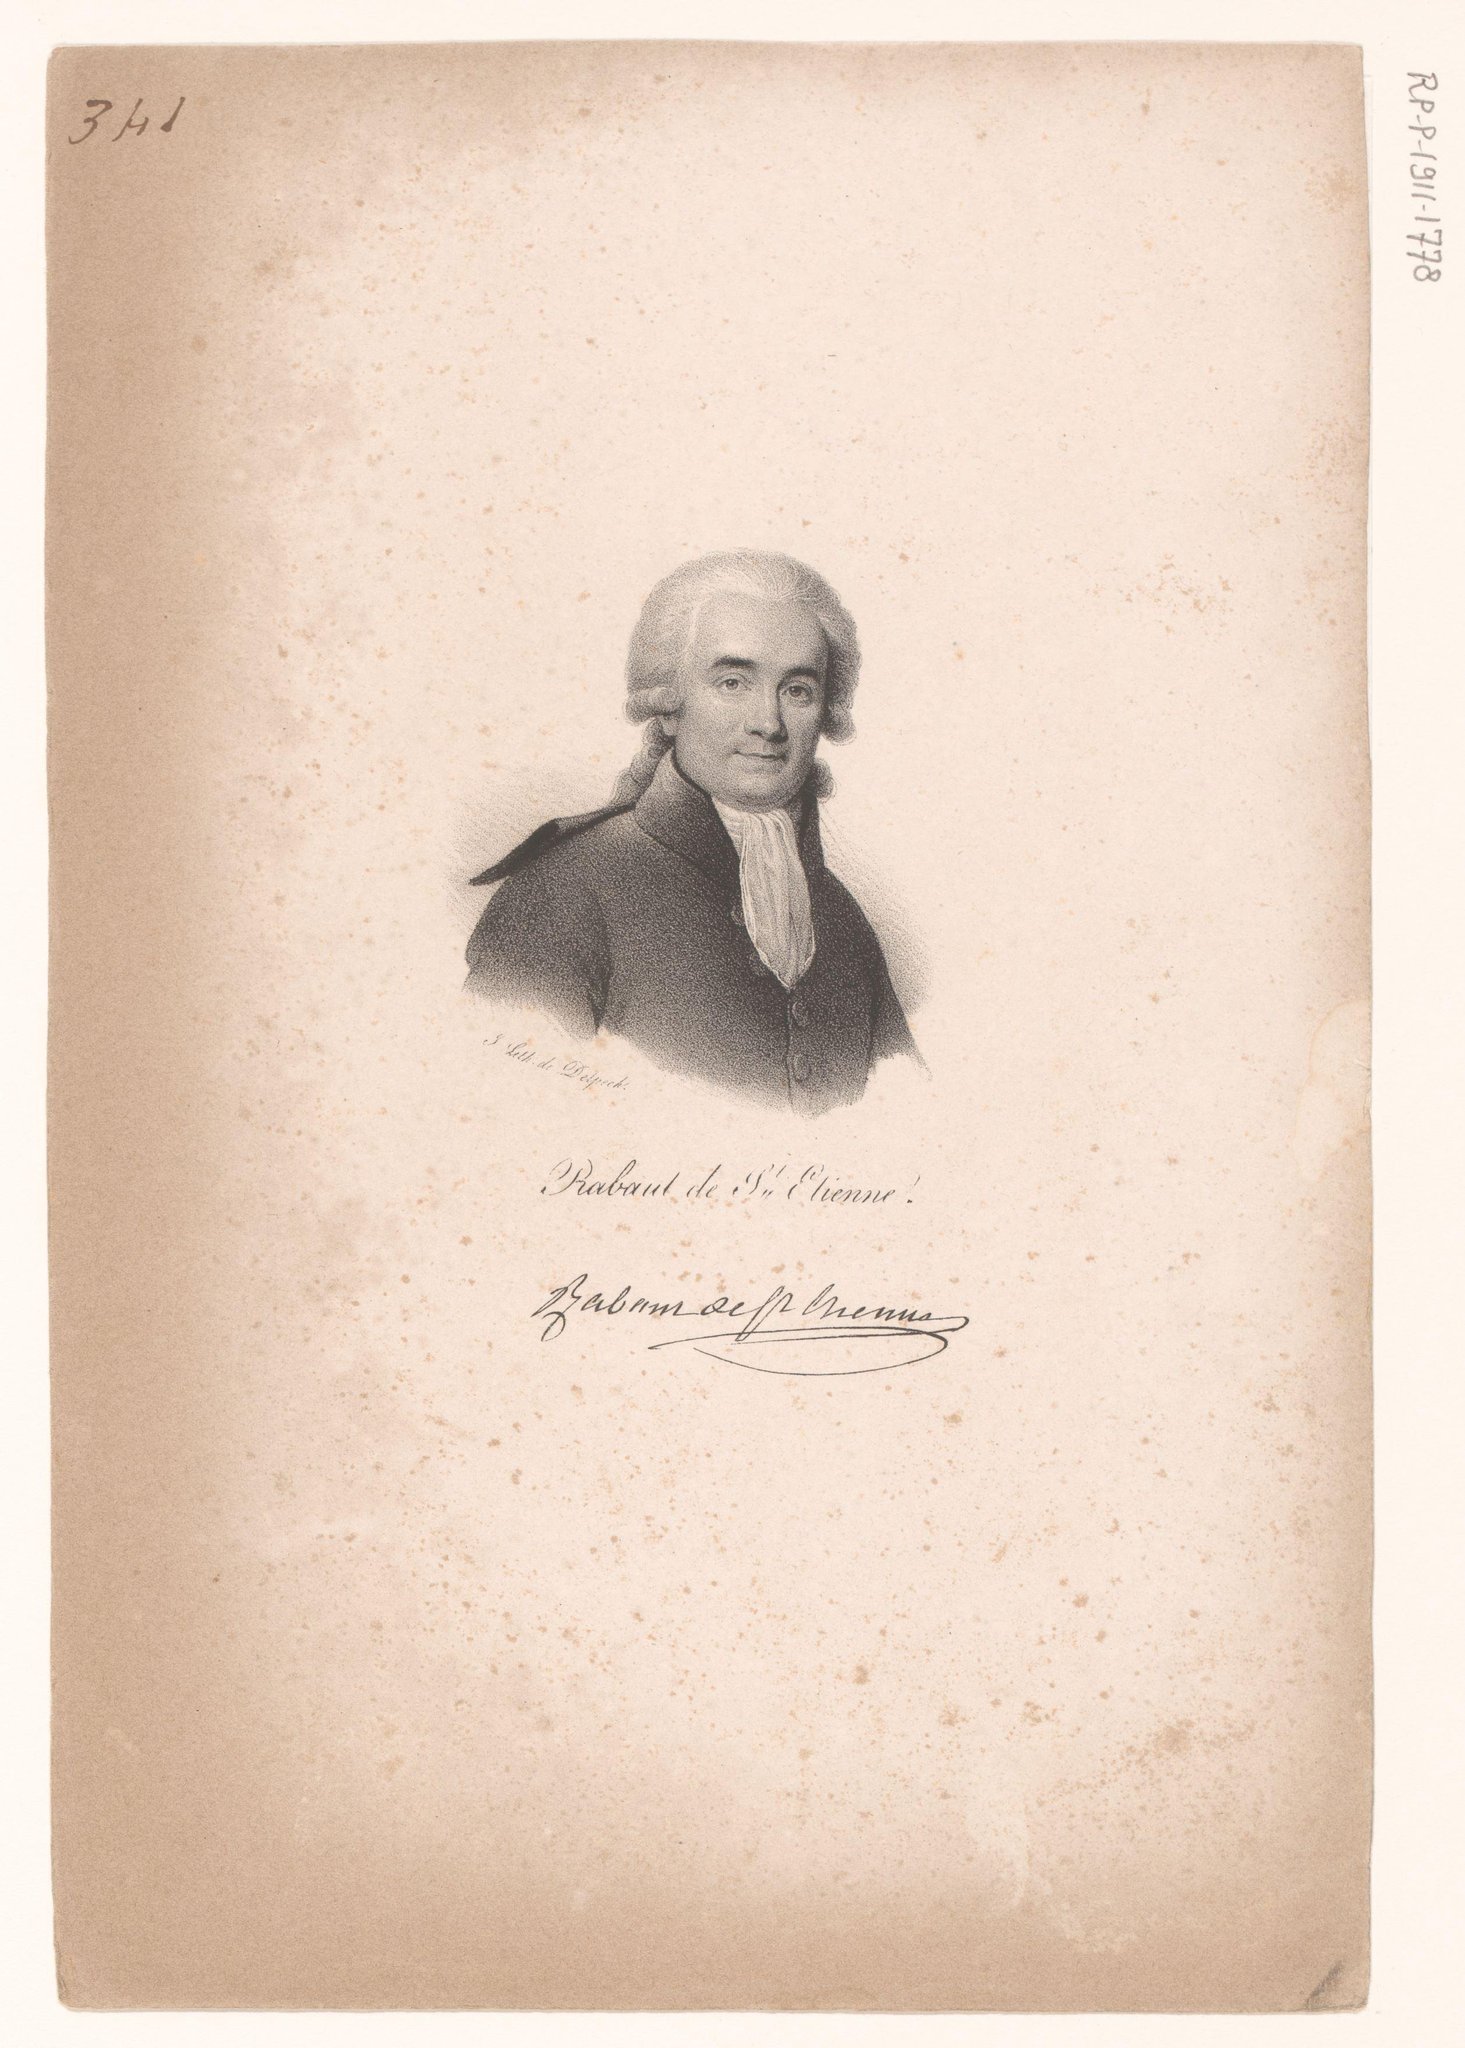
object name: print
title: Rabaut de St. Etienne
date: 1818-1842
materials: paper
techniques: lithograph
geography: paris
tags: historical persons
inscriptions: collector's mark: Lugt 2228a